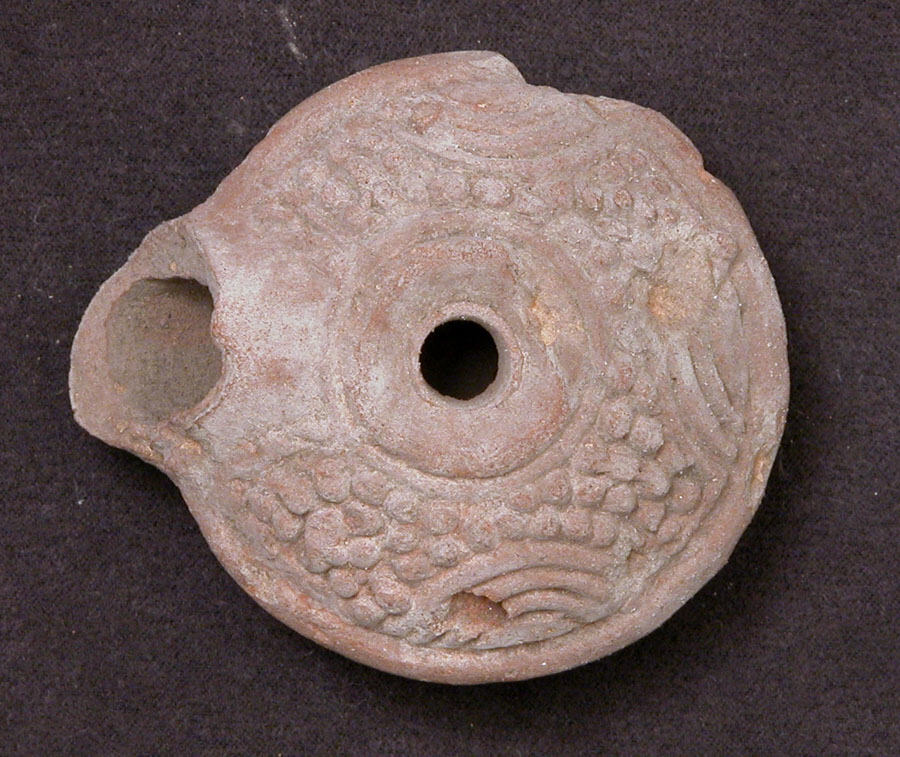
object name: lamp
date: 201-800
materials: earthenware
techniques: molding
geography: egypt